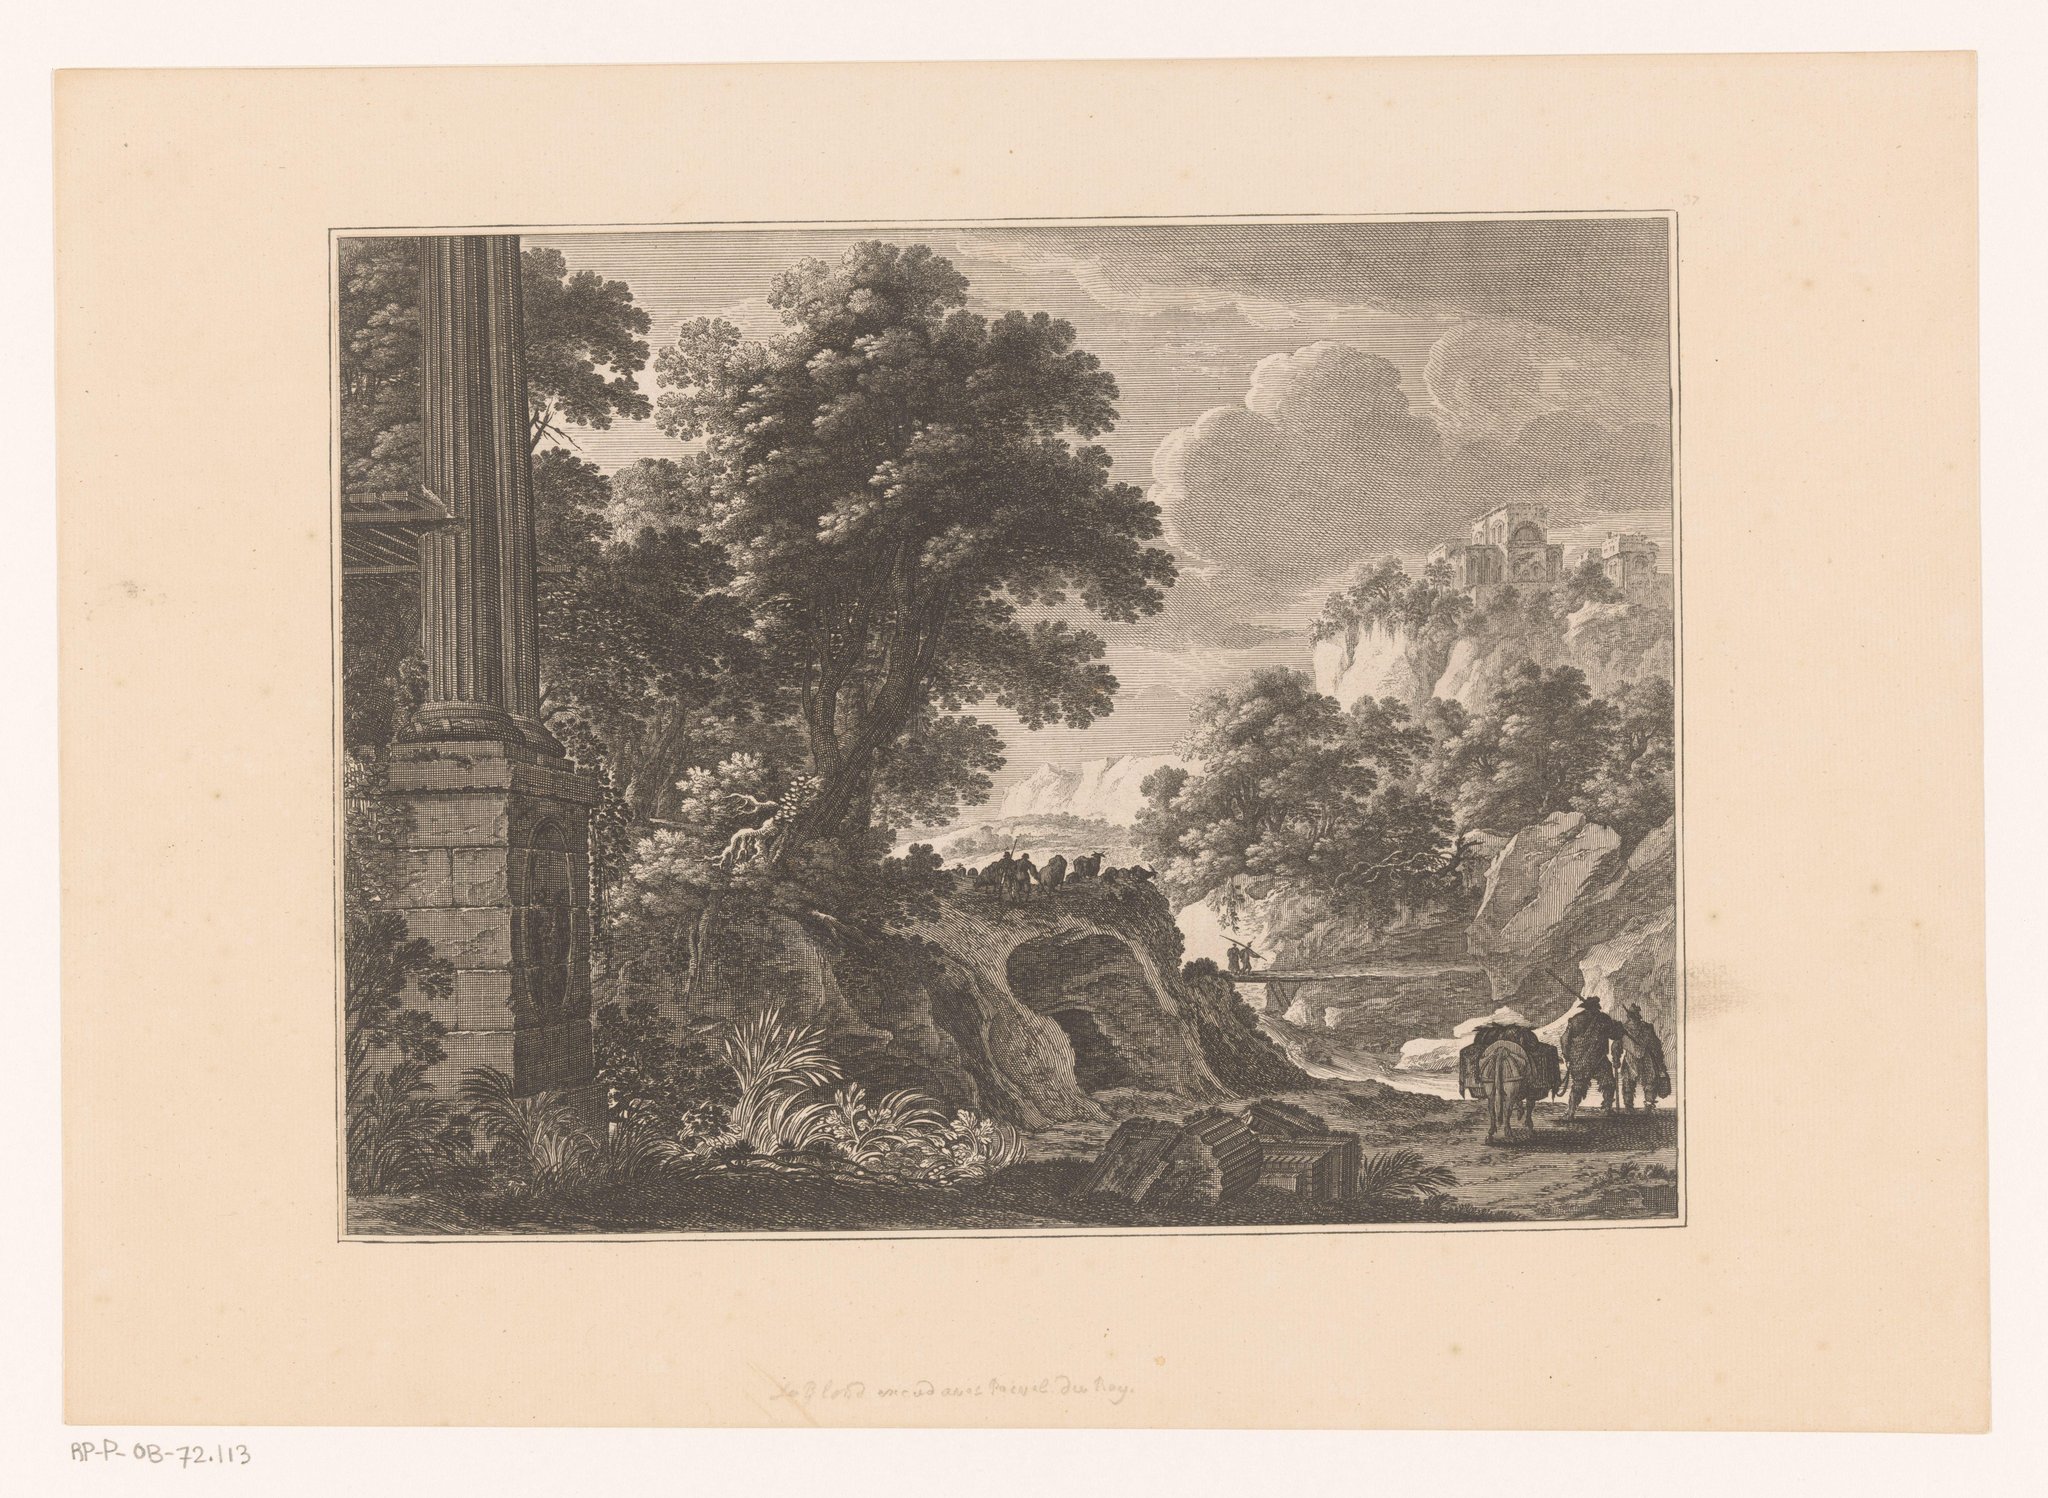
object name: print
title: Landschap met zuilen, herders en reizigers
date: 1613-1695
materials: paper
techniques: engraving, etching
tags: landscape with ruins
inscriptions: collector's mark: Lugt 240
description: Prenten met het signatuur 'Perelle' kunnen zowel door vader Gabriel als door zonen Nicolas en Adam gemaakt zijn.